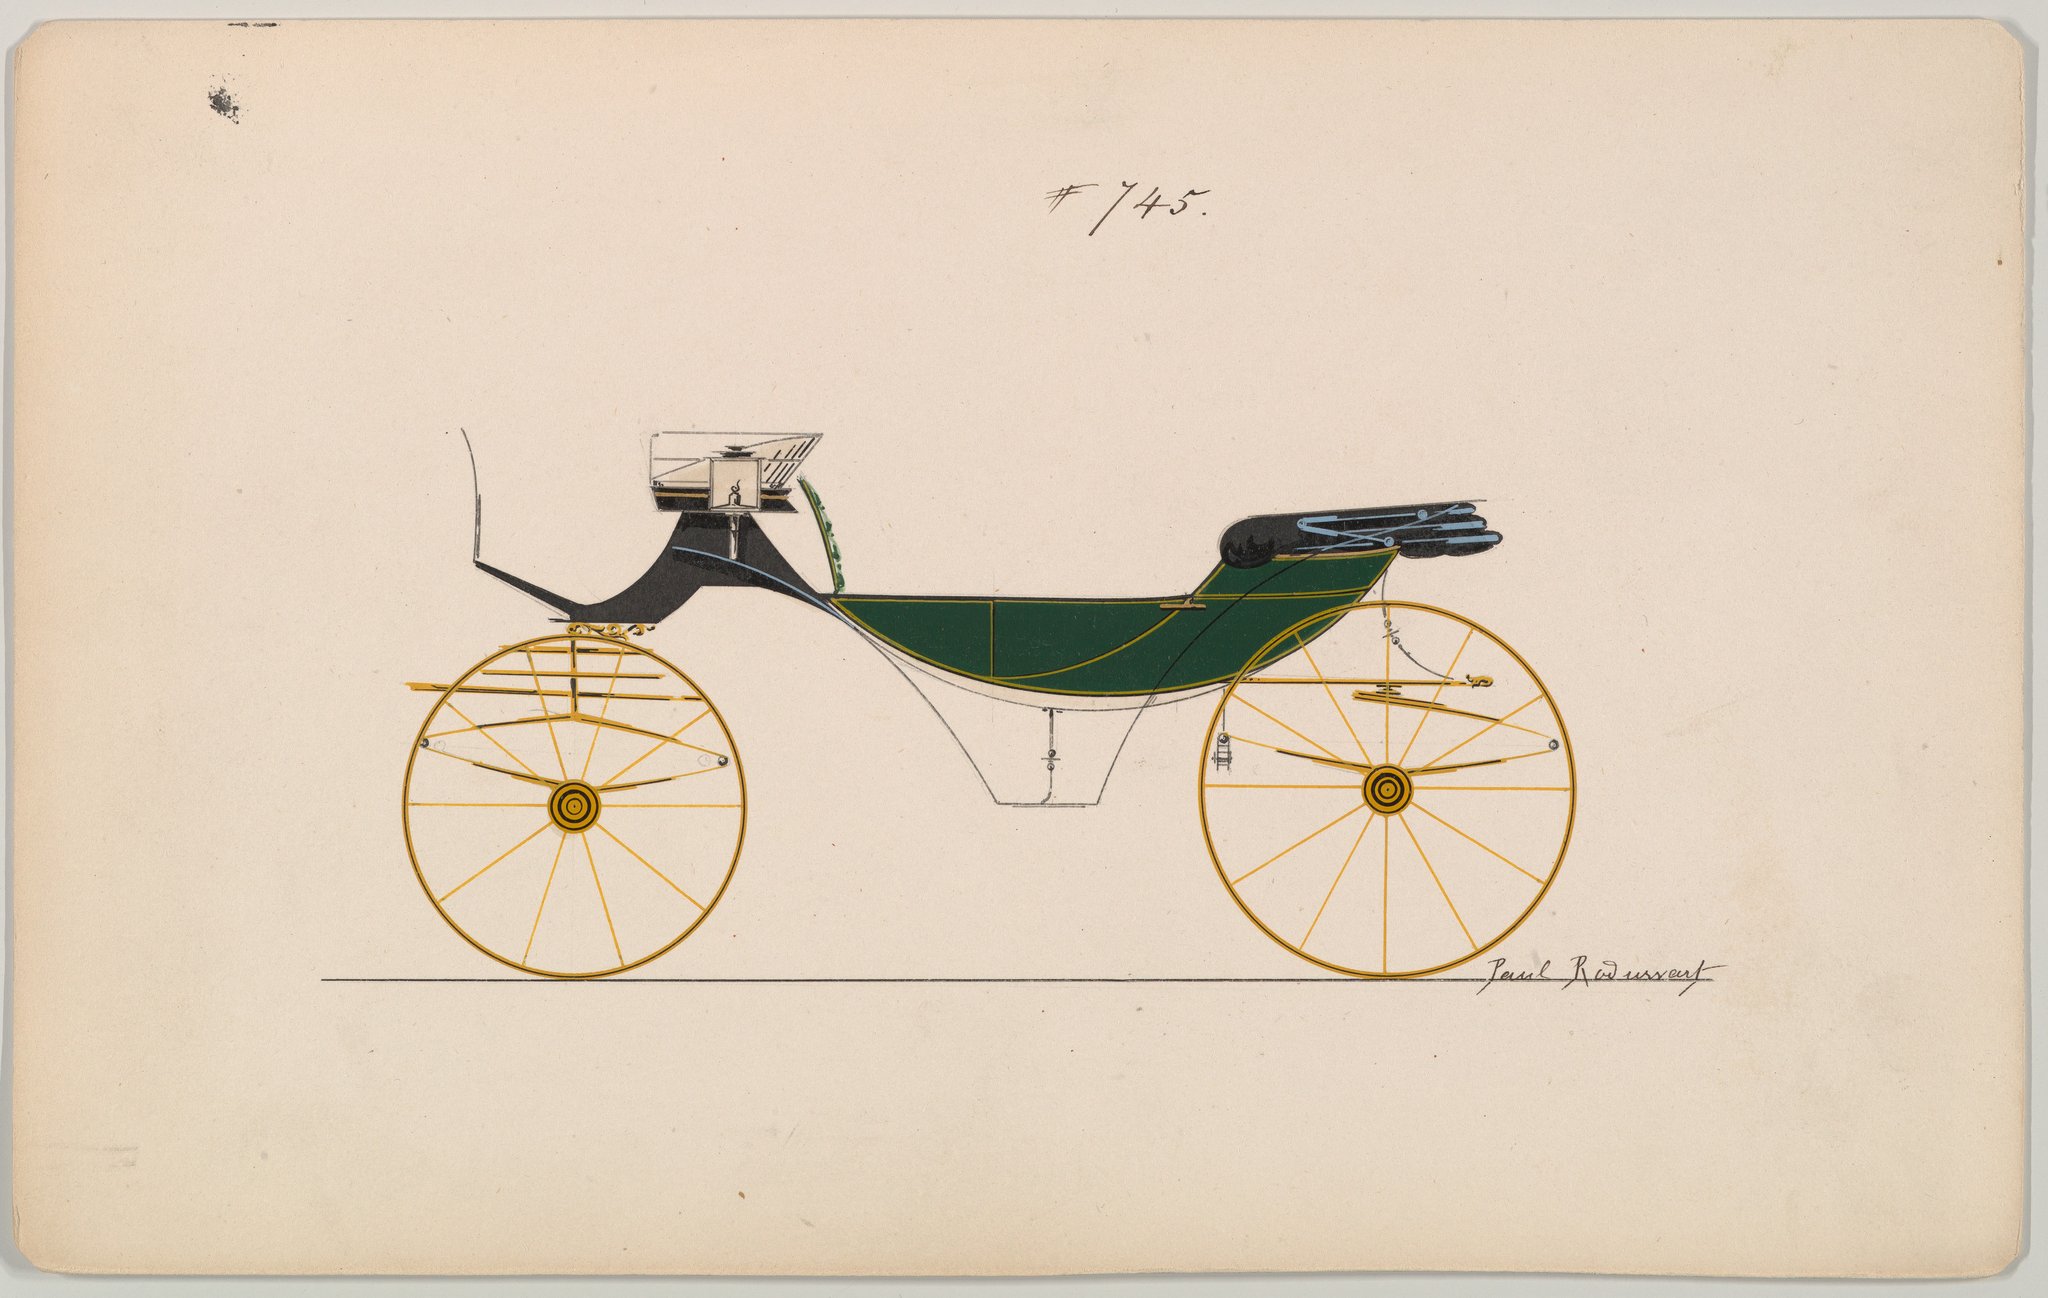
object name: drawing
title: Design for Vis-à-vis/ Caleche, no. 745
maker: brewster & co.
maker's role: manufacturer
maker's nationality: american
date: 1850-1870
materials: gouache, gum arabic, ink, watercolor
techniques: pen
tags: carriages